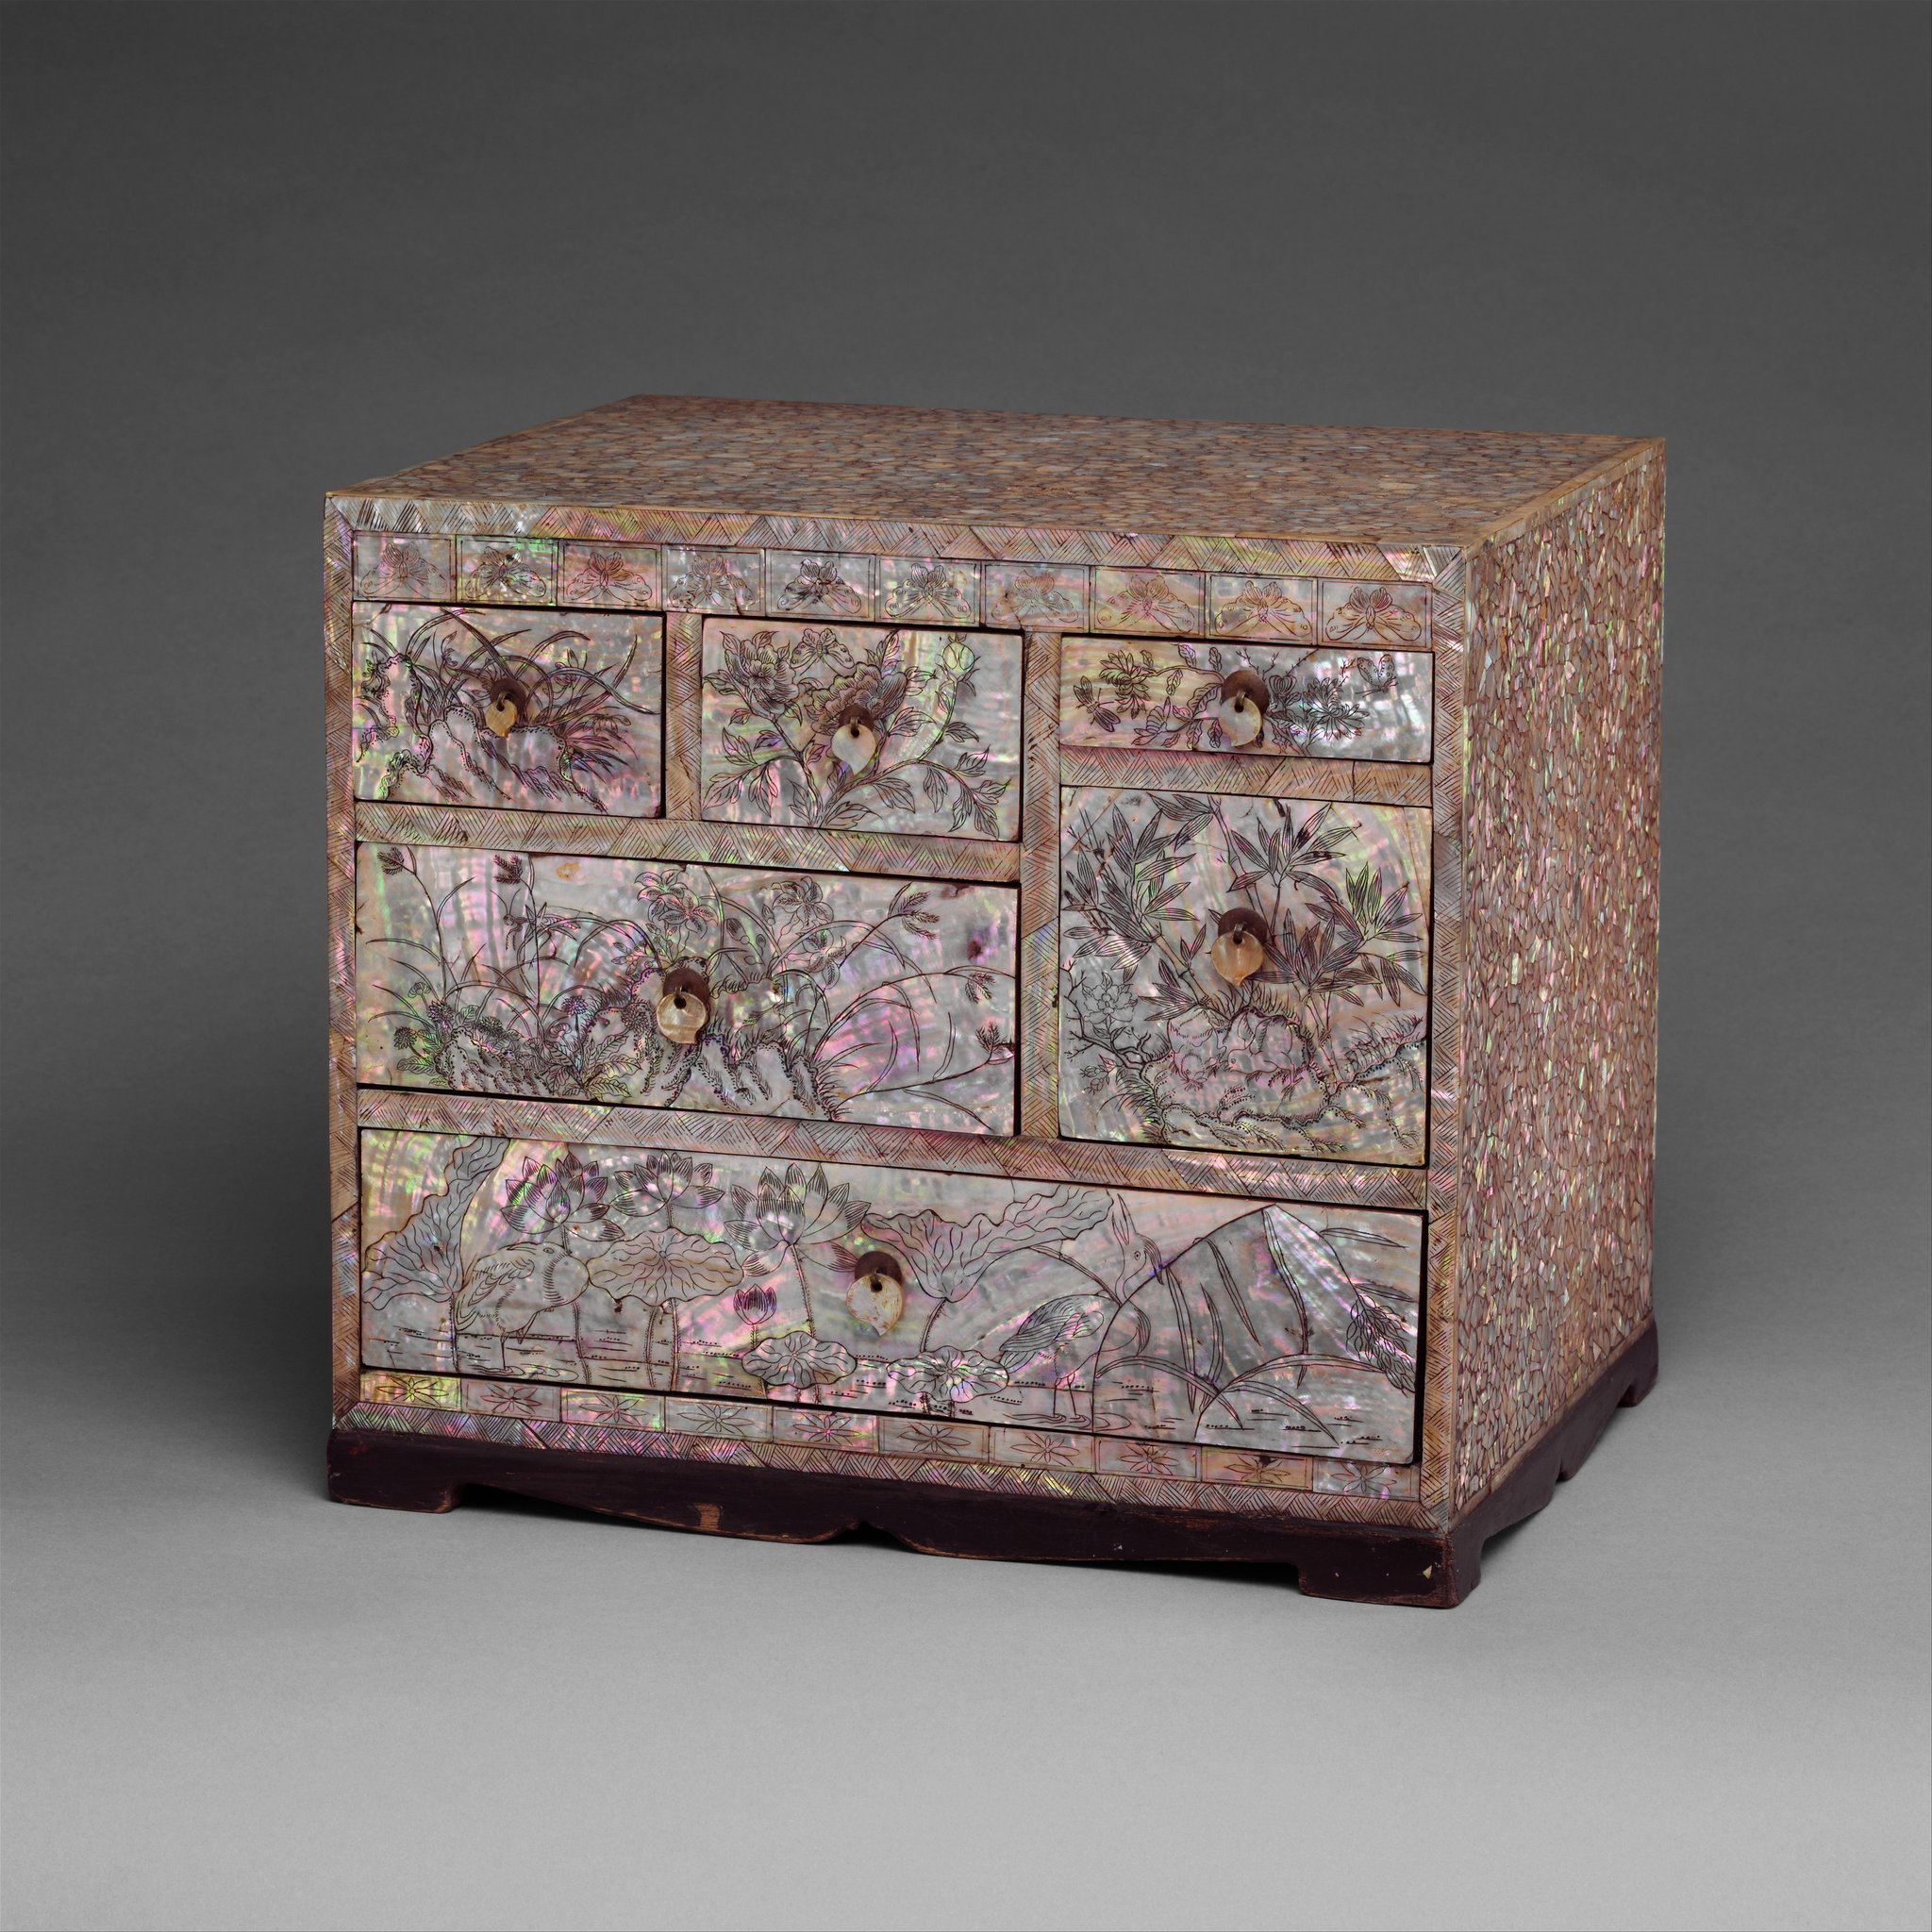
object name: chest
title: Small chest of drawers decorated with flowers, birds, and insects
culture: korean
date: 1901-1933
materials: lacquer, mother of pearl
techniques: incising, inlay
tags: birds,fruit,butterflies,flowers